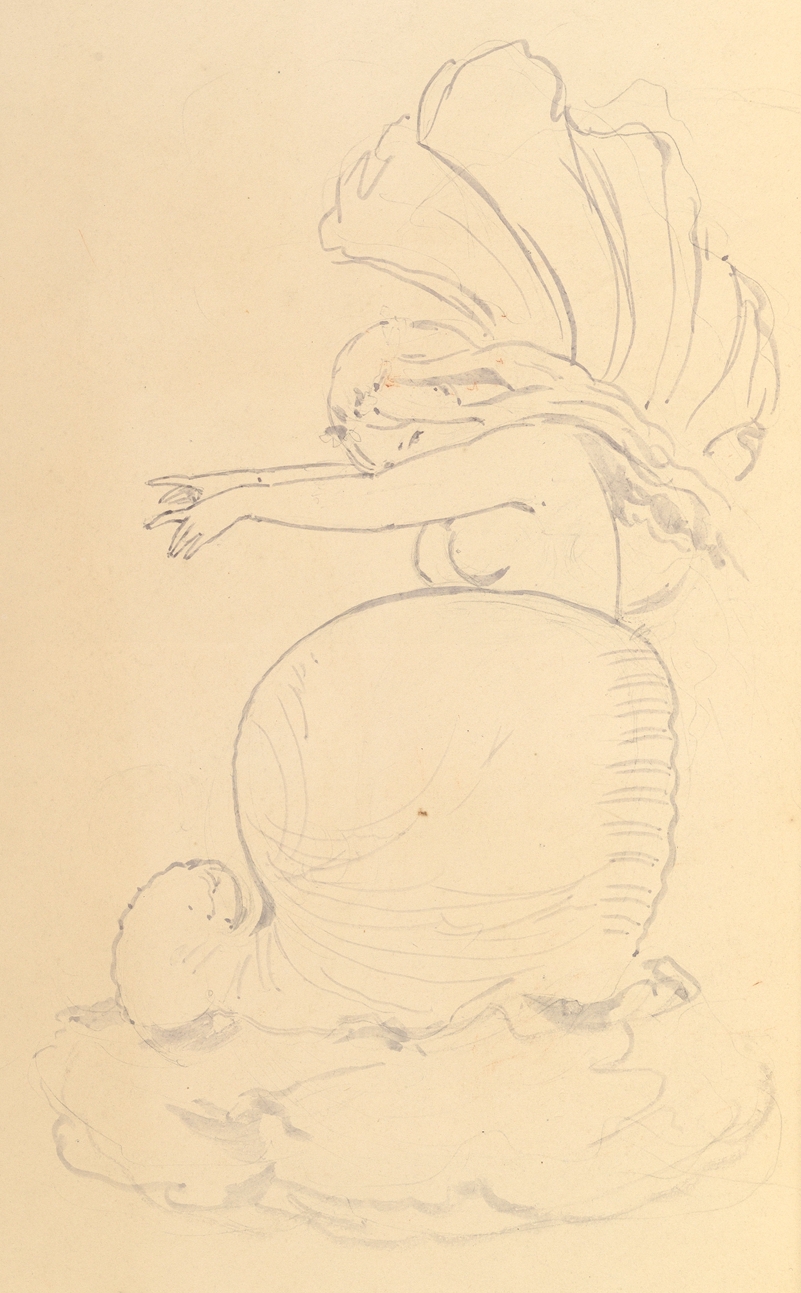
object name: drawing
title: Sketch of a Fairy or Spirit Emerging from a Shell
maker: alfred henry forrester [alfred crowquill]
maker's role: artist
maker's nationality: british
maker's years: 1804-1872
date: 1845-1855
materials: graphite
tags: fairies,shells